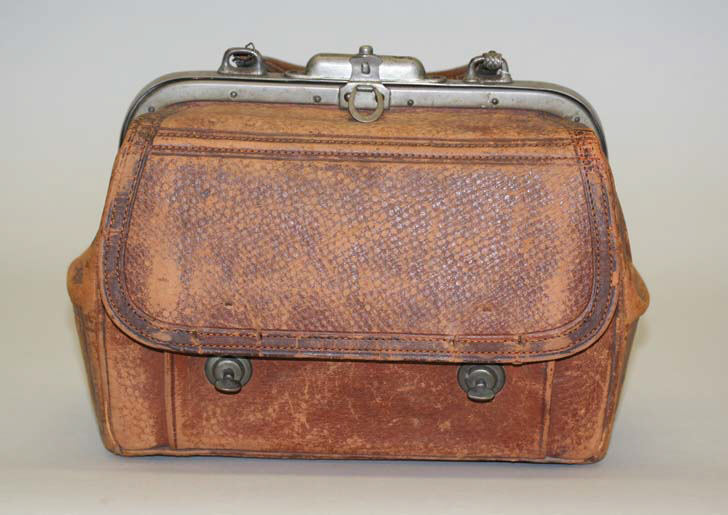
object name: satchel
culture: american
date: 1834-1866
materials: leather